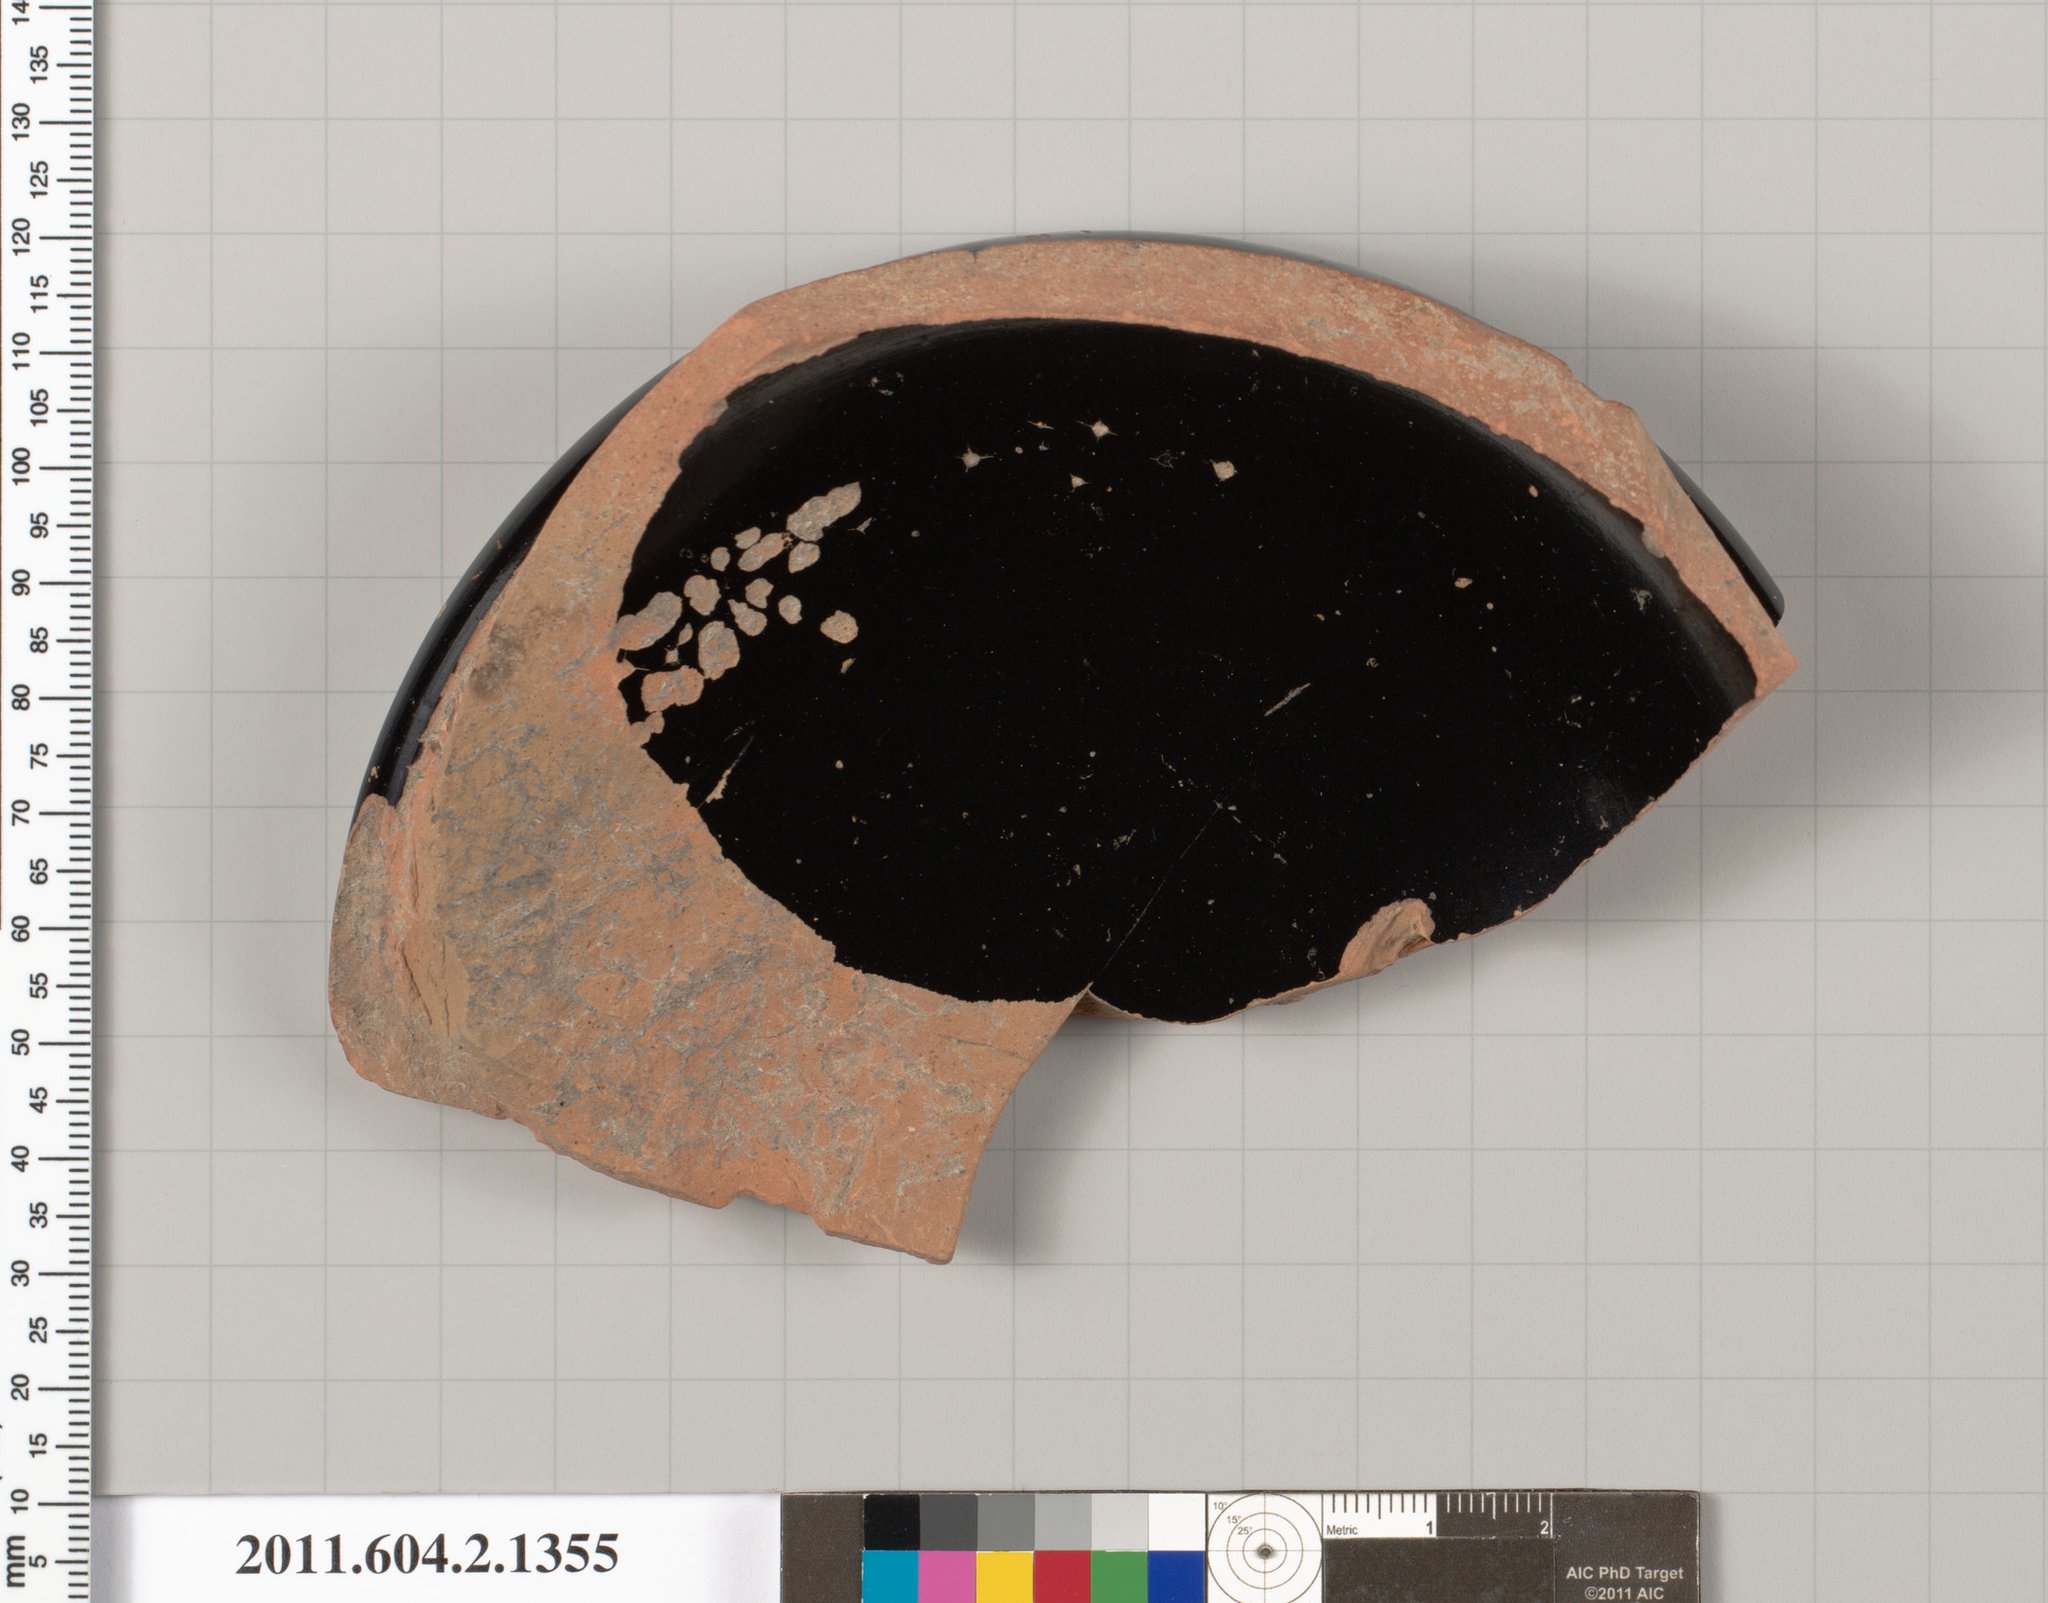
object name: skyphos fragment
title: Terracotta fragment of a skyphos (deep drinking cup)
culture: greek, attic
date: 475-451 BCE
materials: terracotta